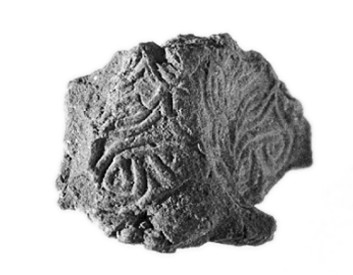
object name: sealing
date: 1981-1640 BCE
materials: mud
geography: egypt